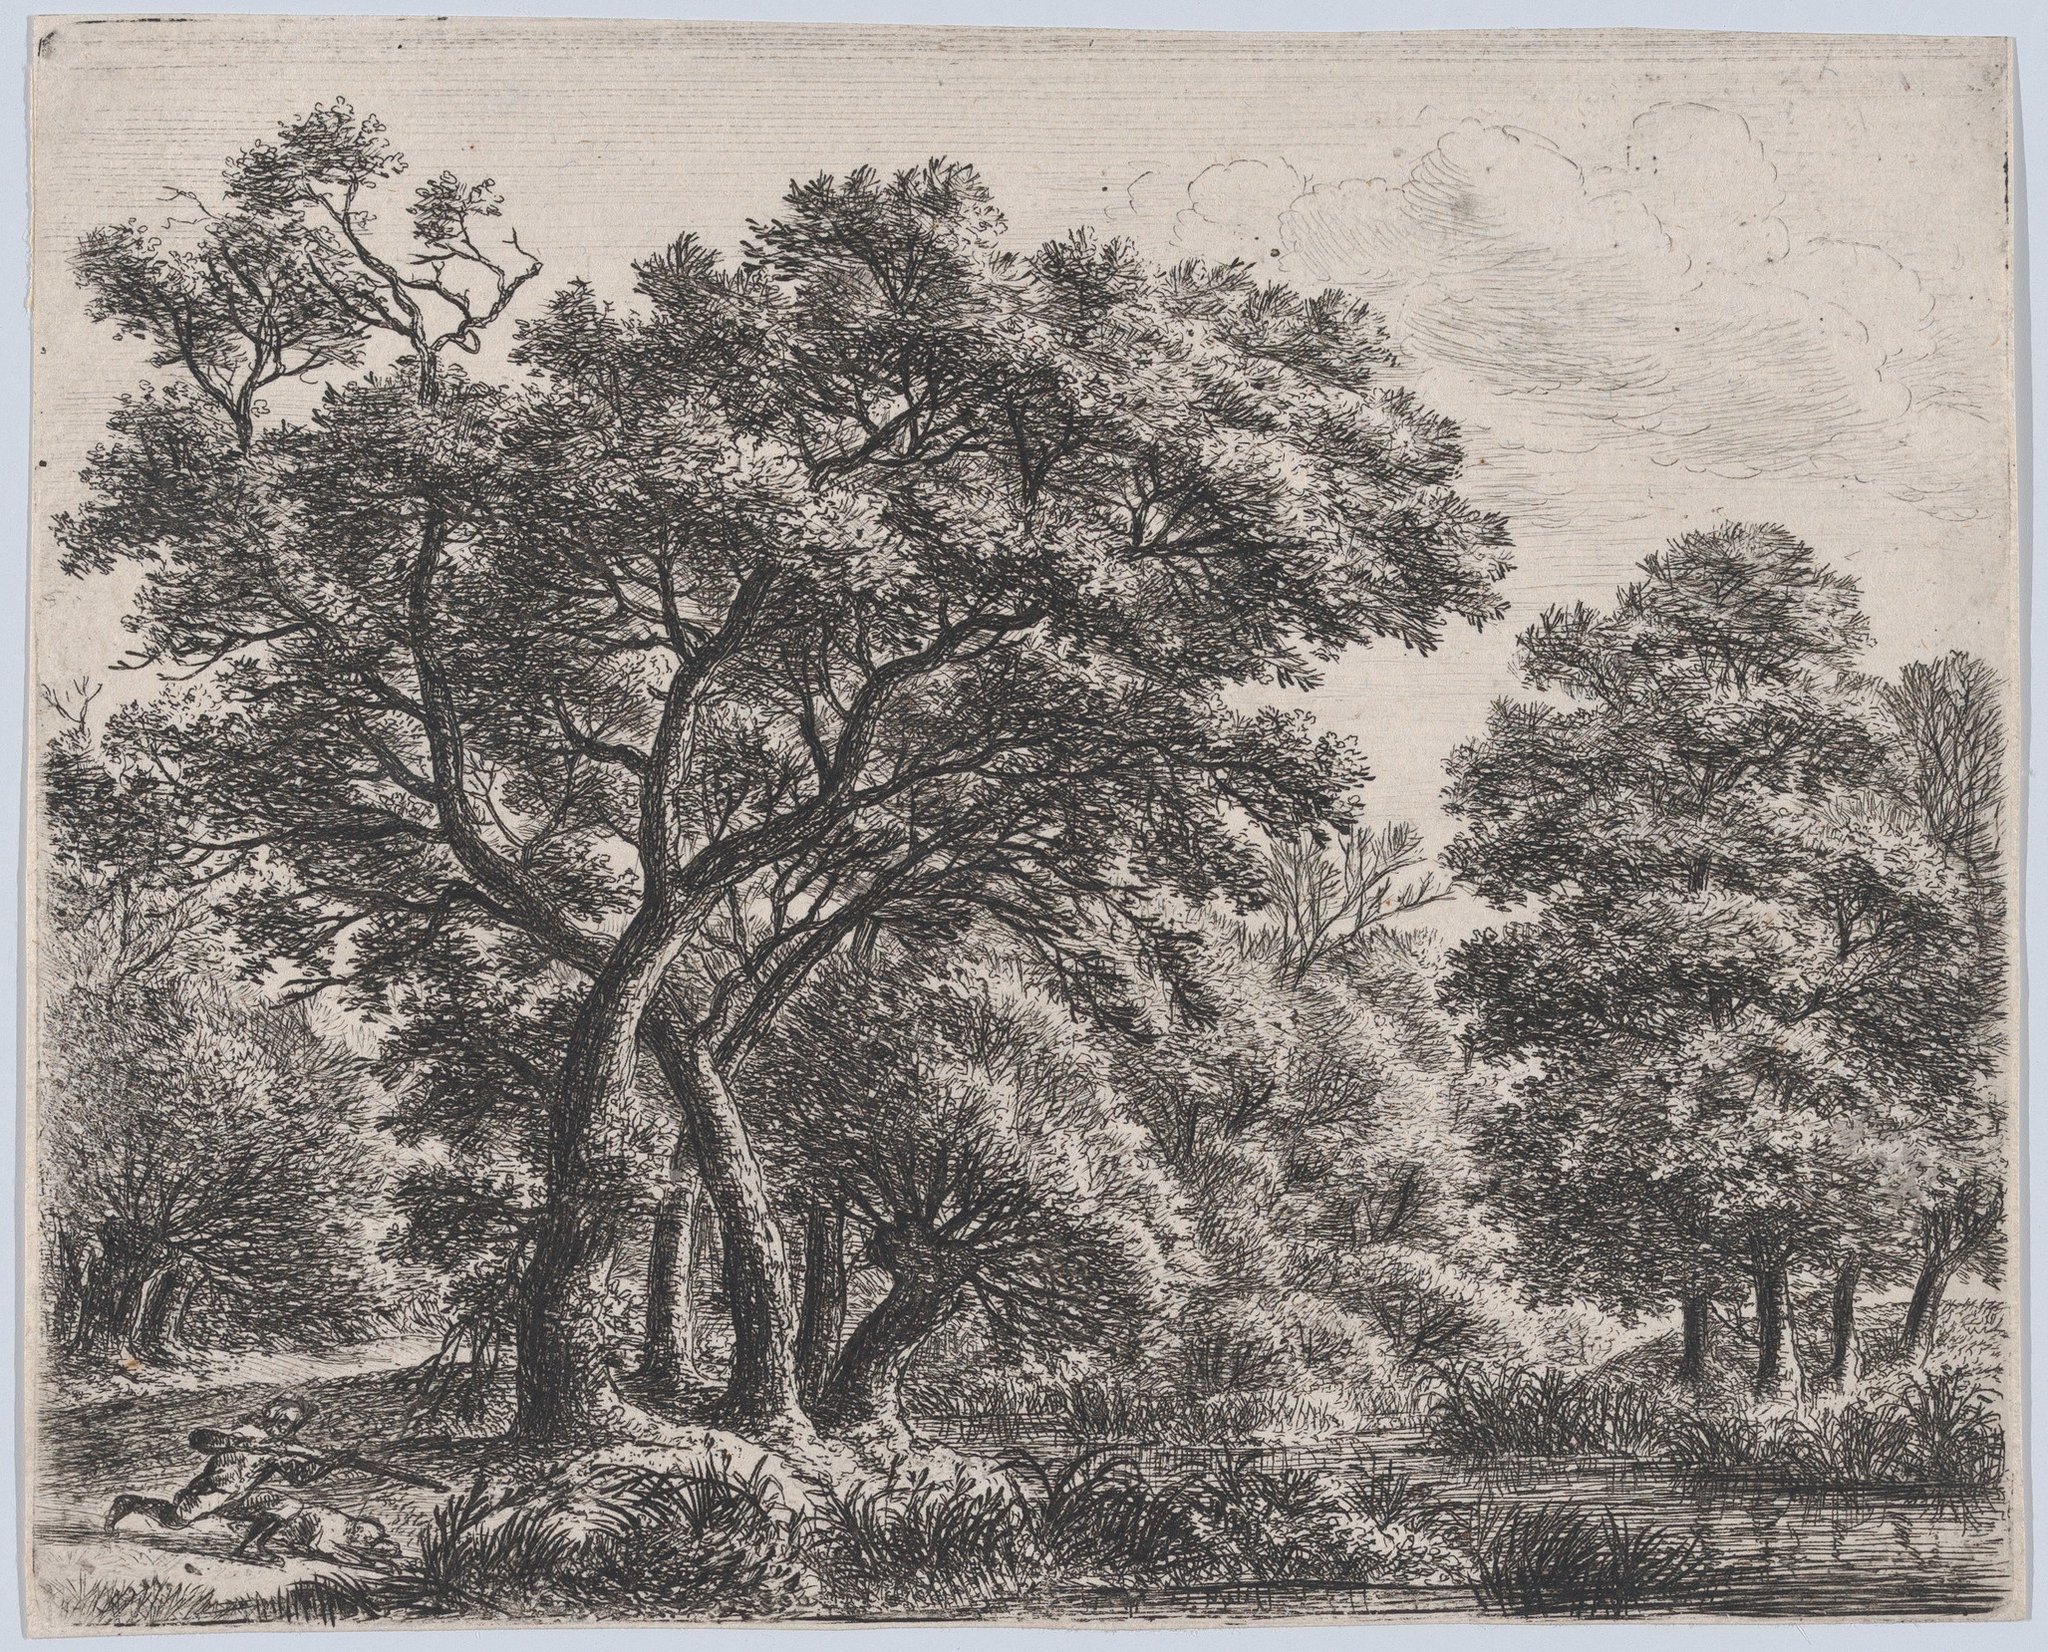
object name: print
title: The Duck Hunter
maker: anthonie waterloo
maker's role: artist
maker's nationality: dutch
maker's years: 1609-1690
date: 1601-1700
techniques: etching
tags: men,hunting,landscapes